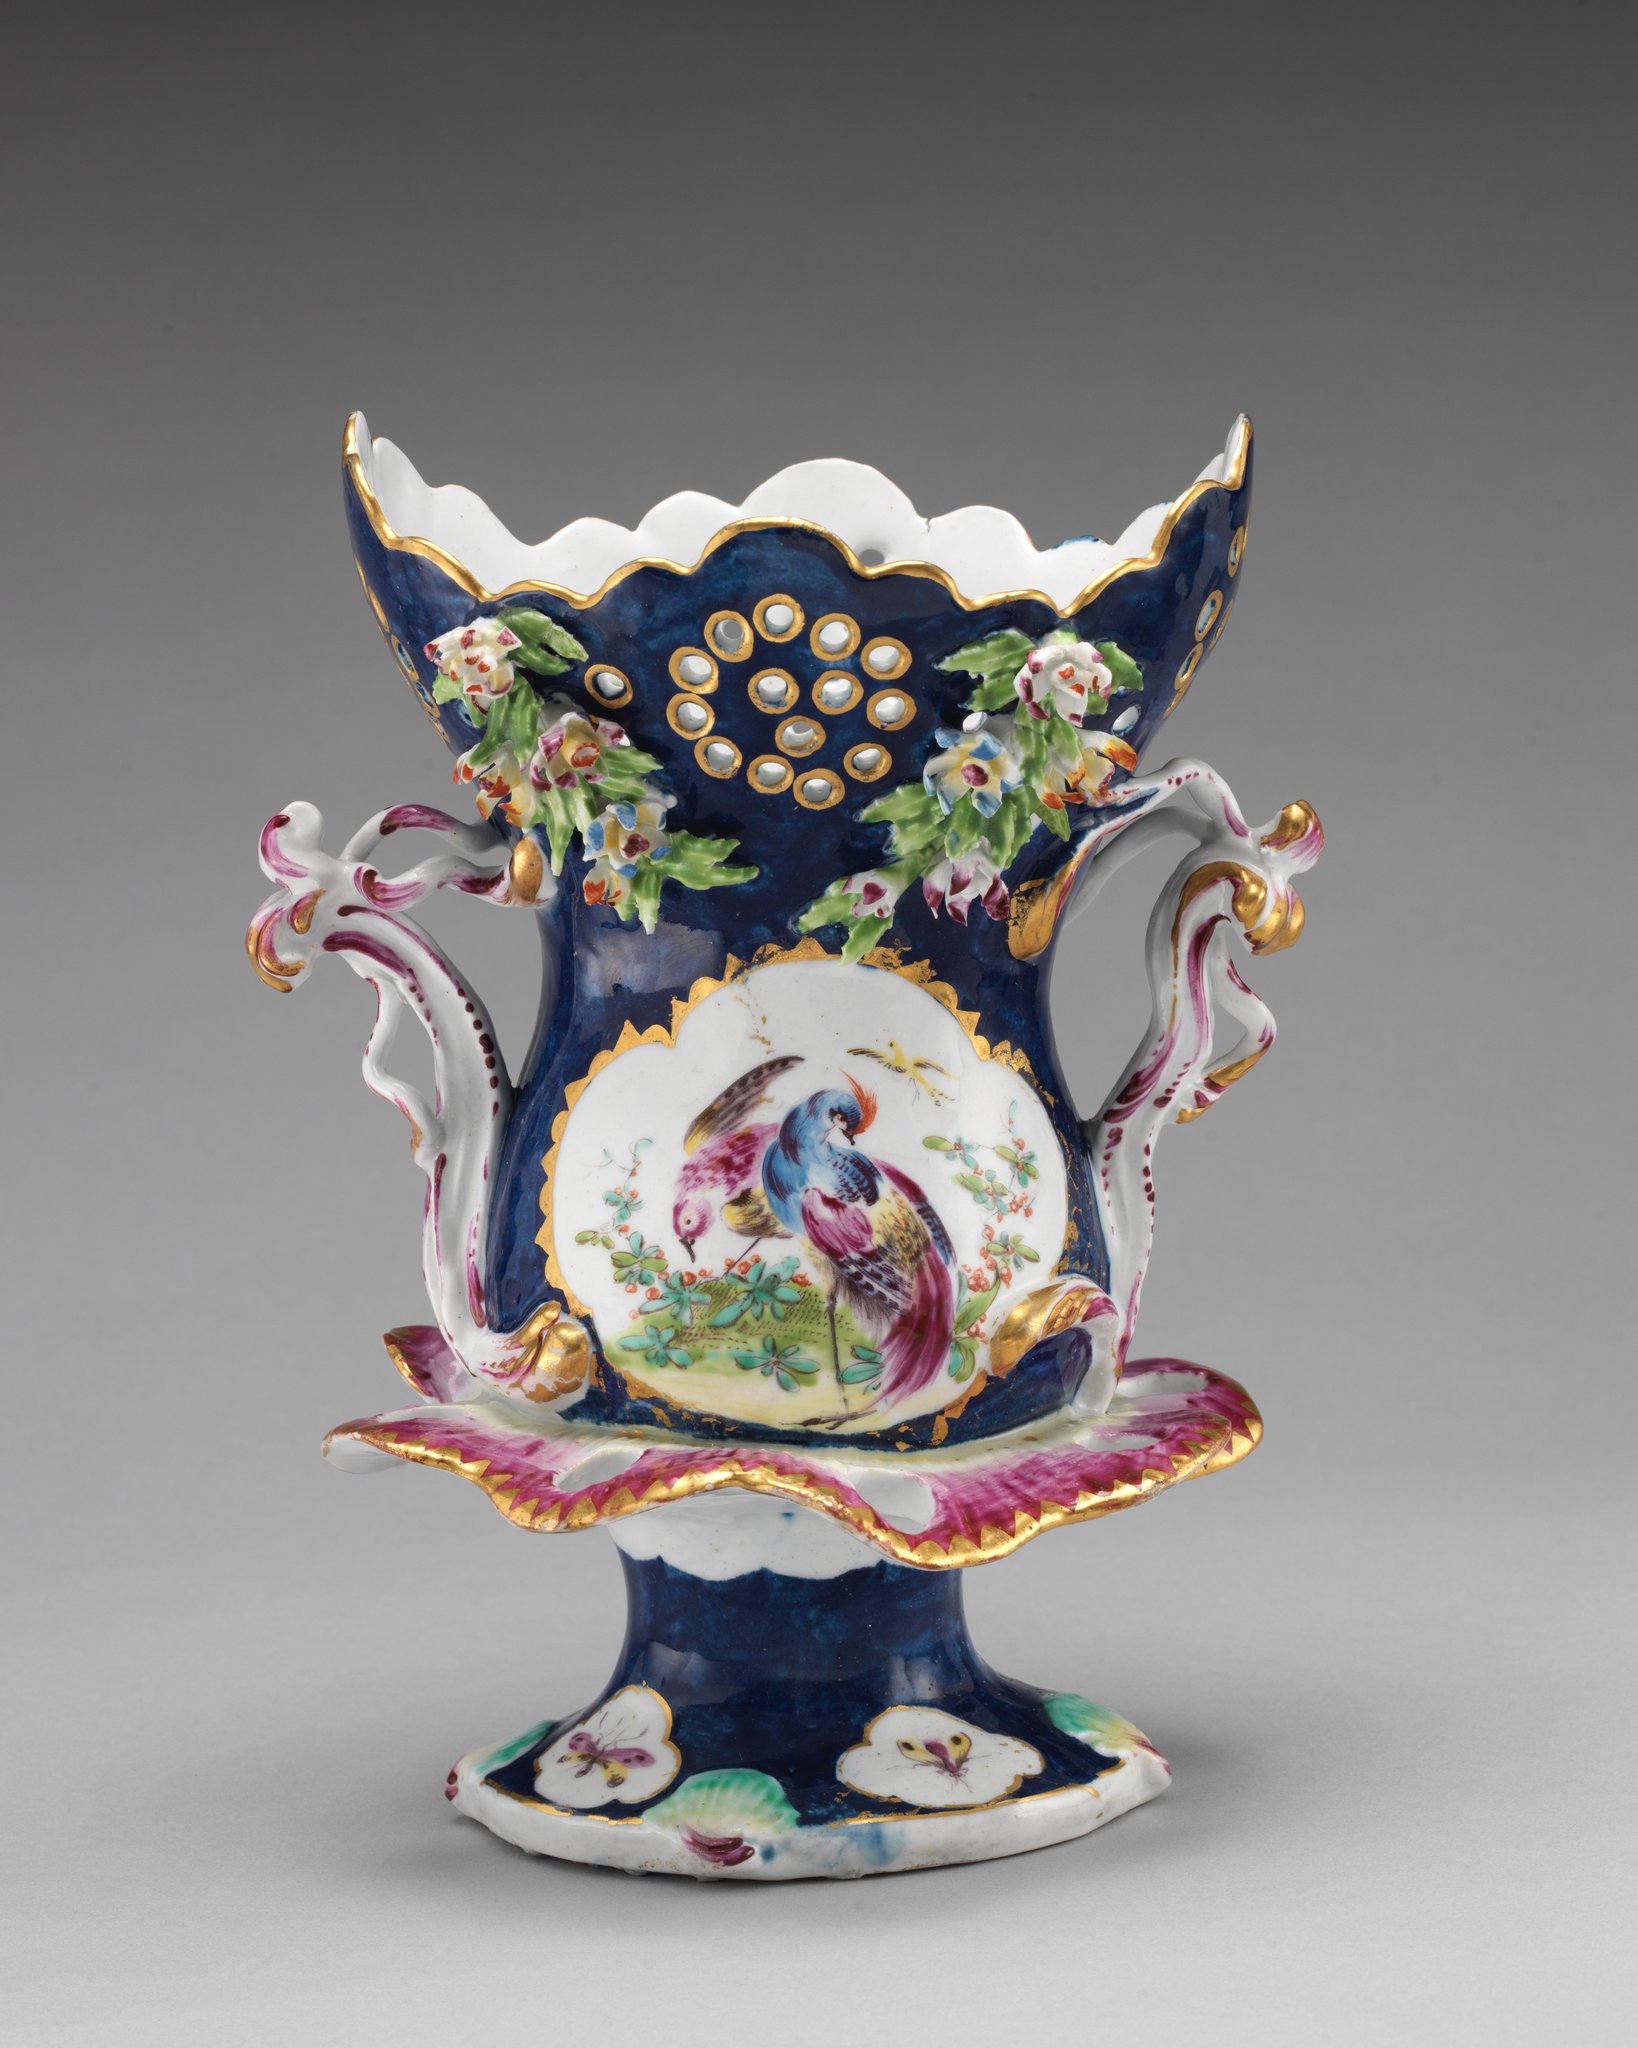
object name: beaker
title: Beaker (part of a garniture)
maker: bow porcelain factory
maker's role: factory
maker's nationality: british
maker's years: 1747-1776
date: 1765-1770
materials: soft paste porcelain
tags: birds